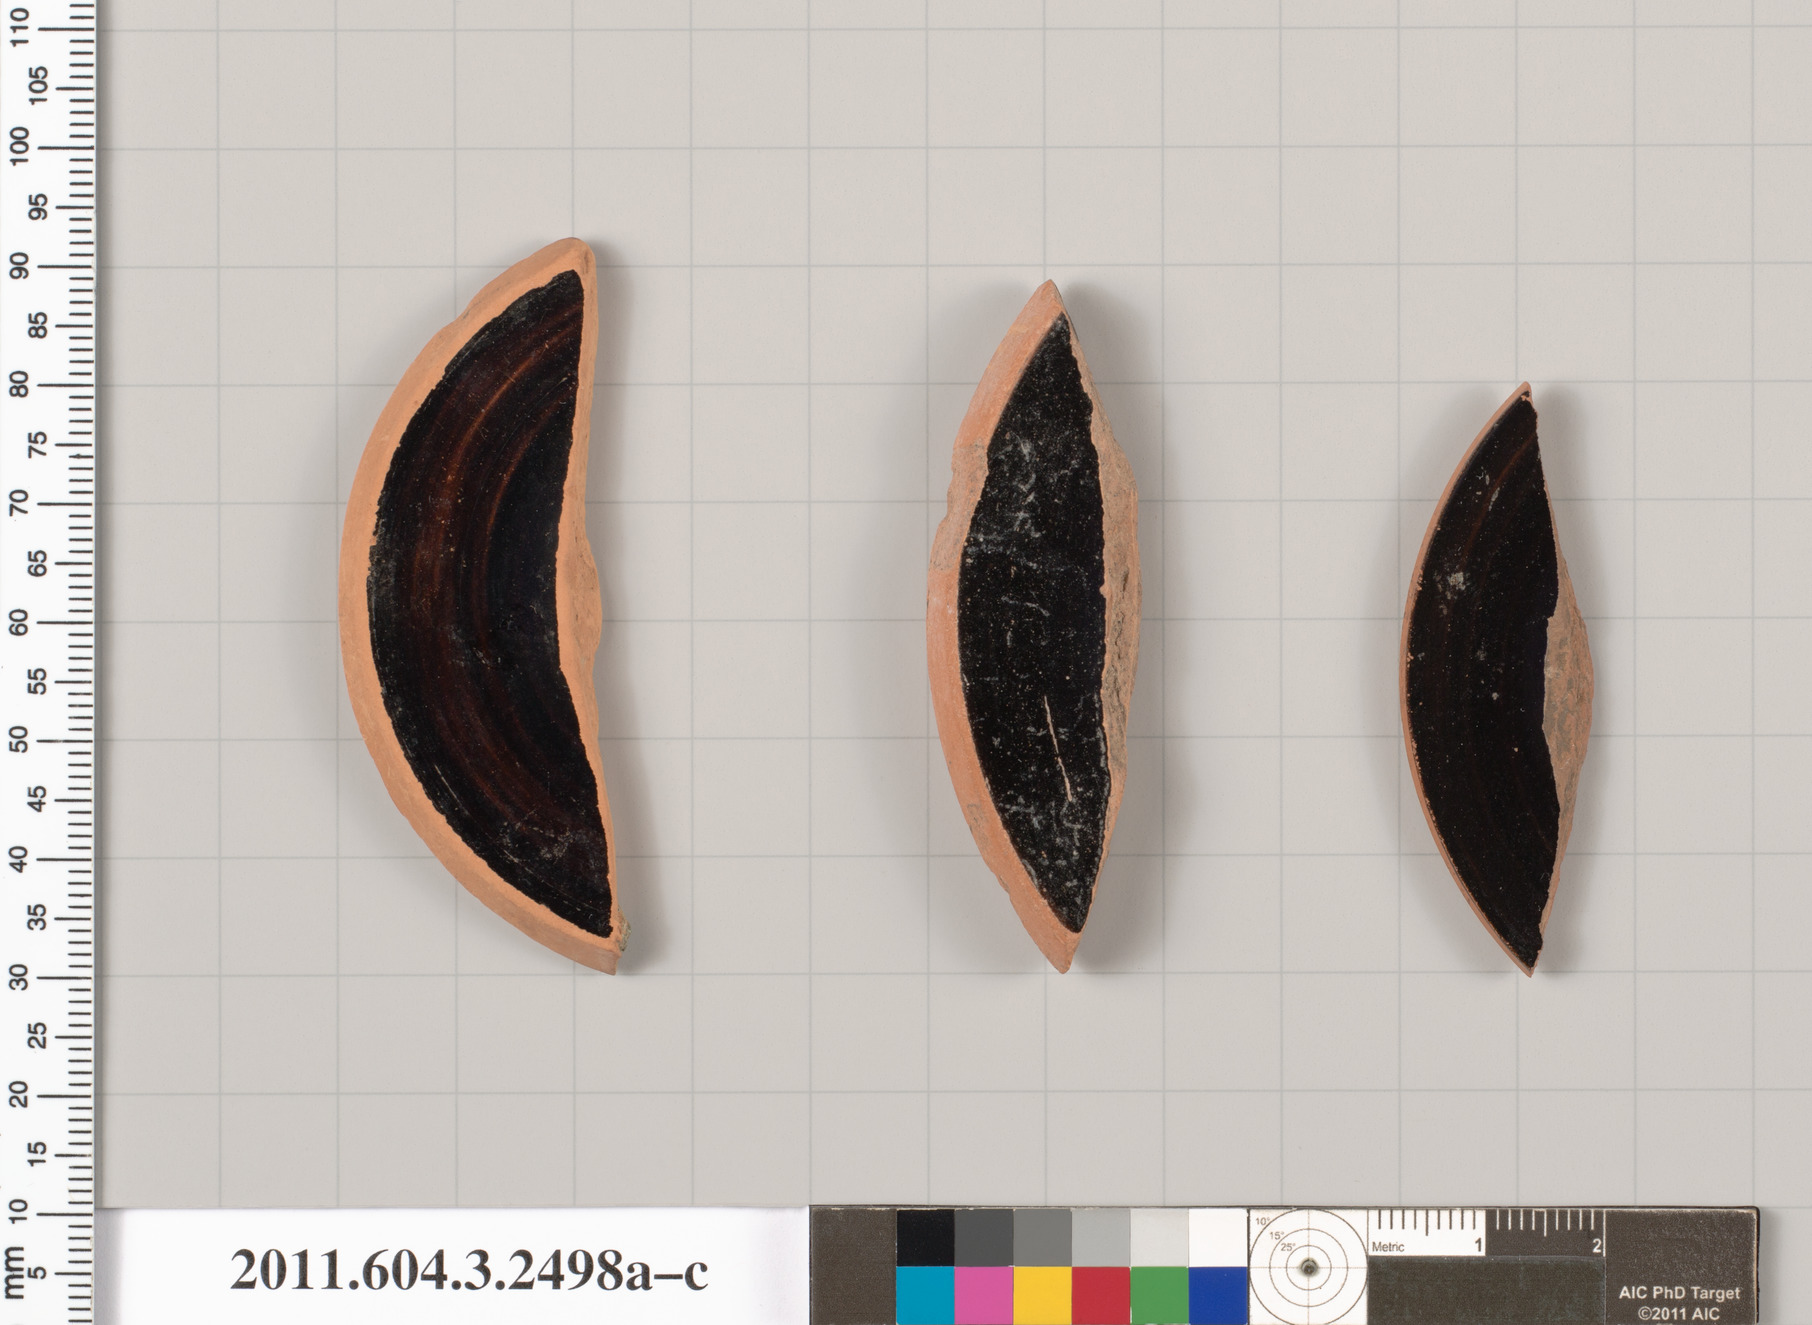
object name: kylix fragment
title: Terracotta fragment of a kylix (drinking cup)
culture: greek, attic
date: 600-401 BCE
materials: terracotta